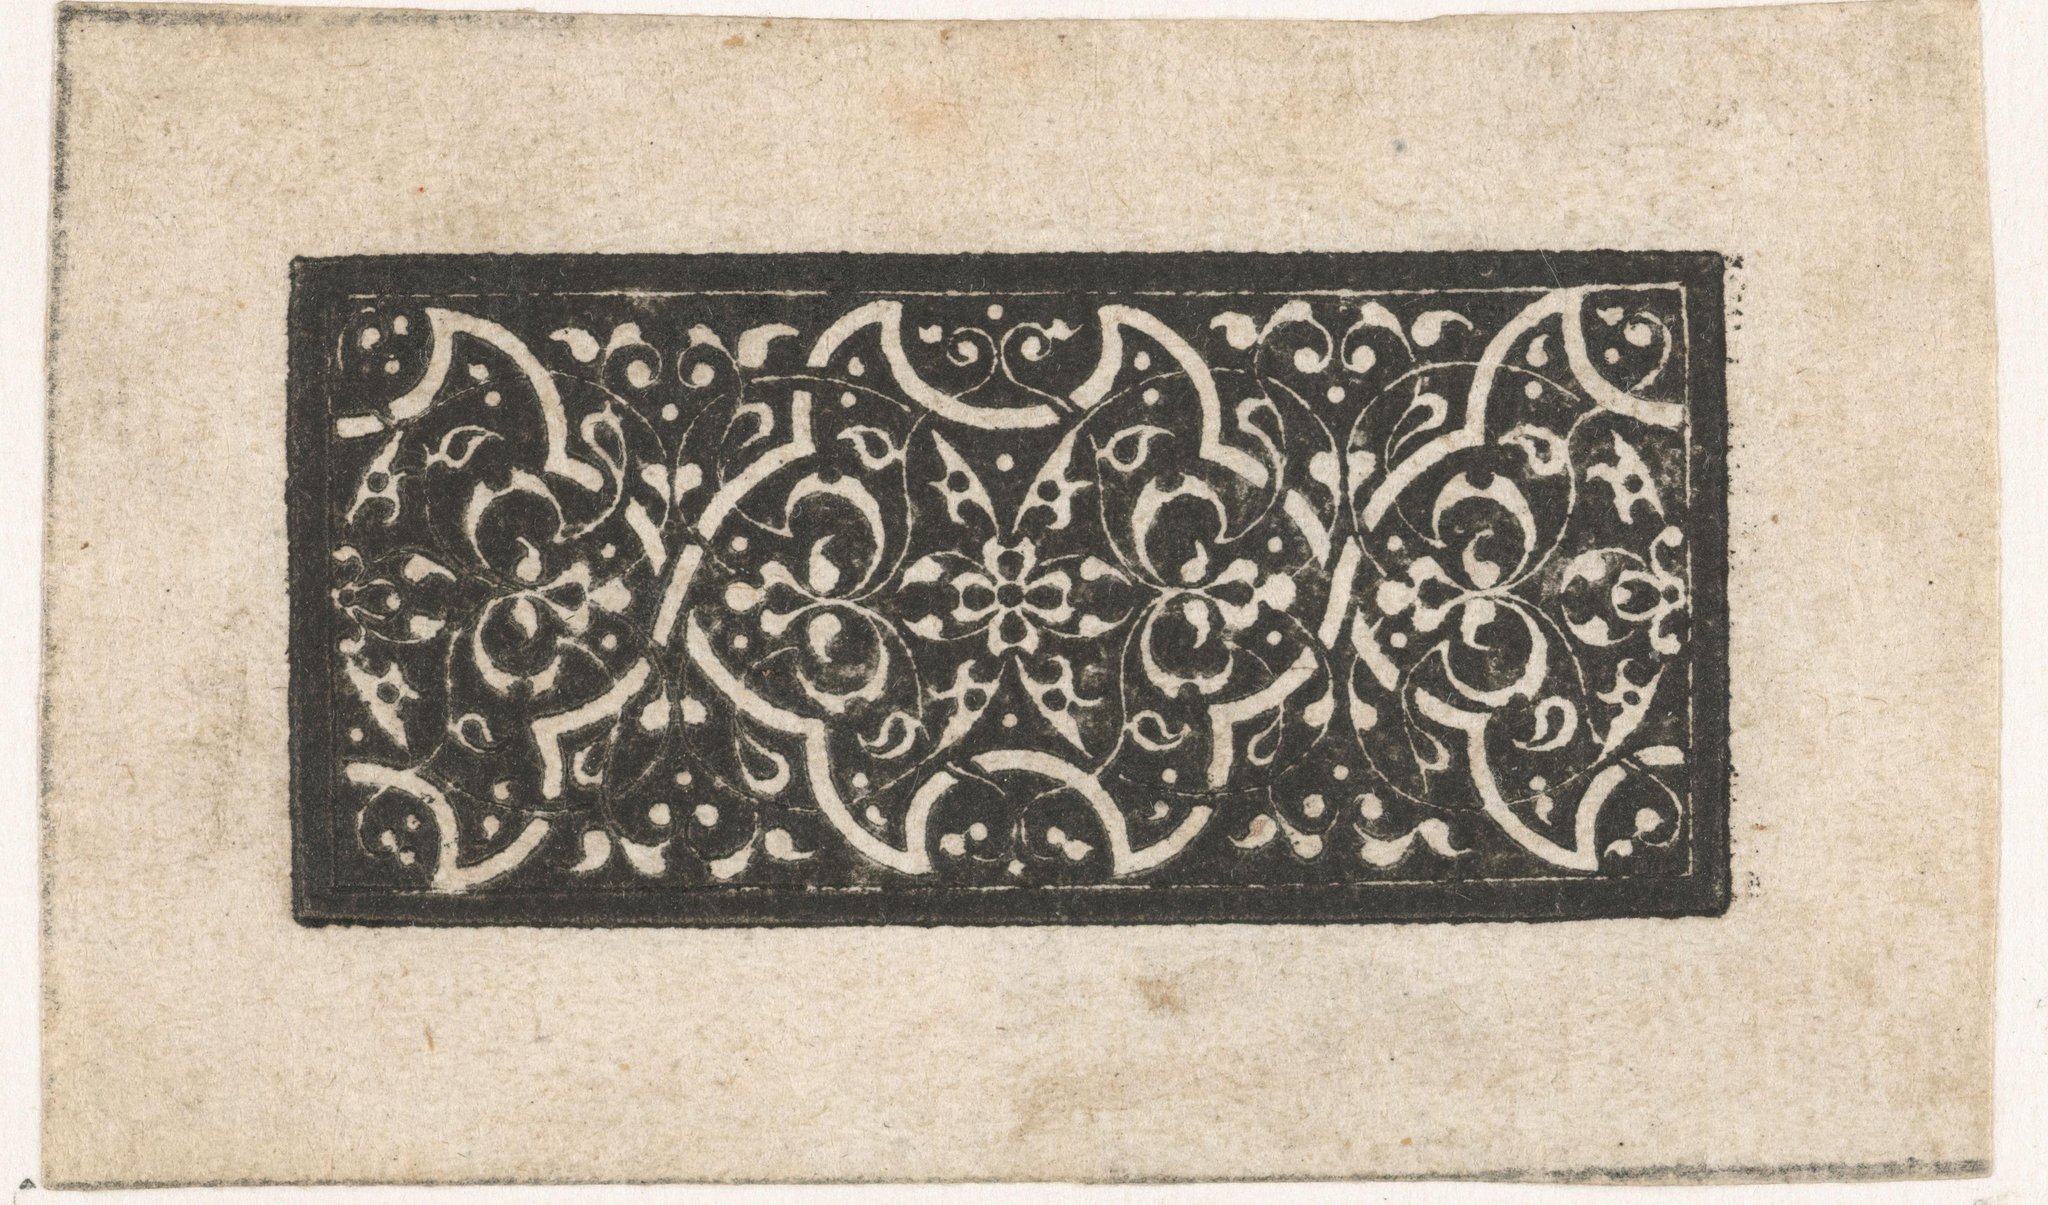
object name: print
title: Moresken en arabesken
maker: Anonymous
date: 1516-1571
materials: paper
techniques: woodcut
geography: france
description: Moresken en arabesken in een motief dat één maal in het midden wordt weergegeven en zowel links als rechts daarvan nog eens voor de helft zichtbaar is.